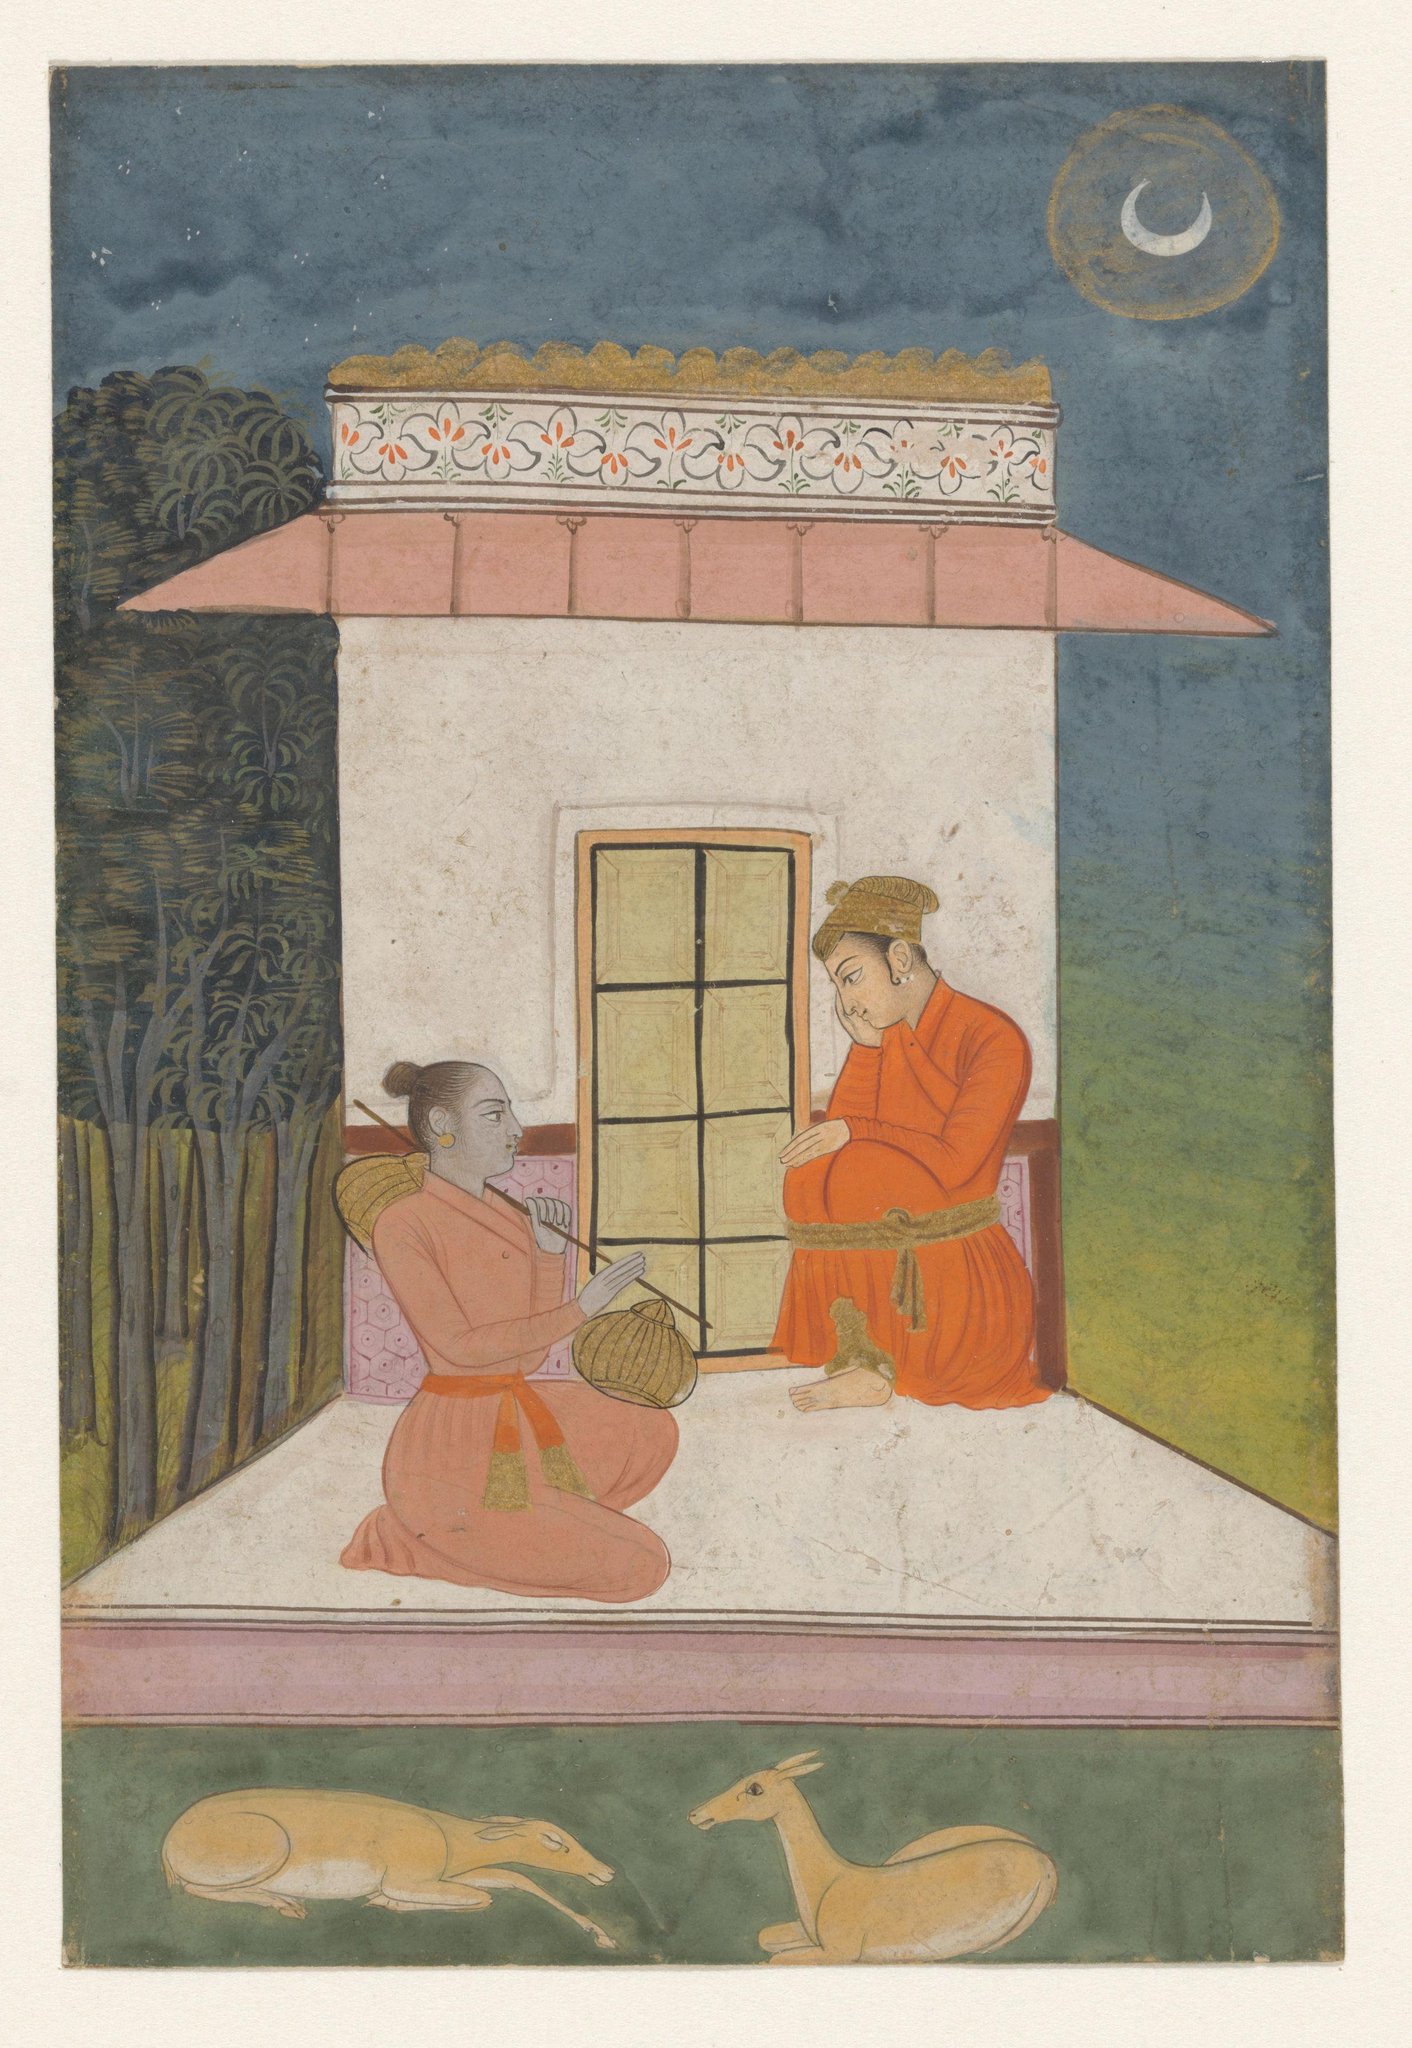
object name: drawing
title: Kedara raga, man en vrouw zittend voor een gebouwtje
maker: Anonymous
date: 1775-1800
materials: paint, gouache, paper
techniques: brush, pen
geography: india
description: Kedara Ragini // Kedararagini. Een man en een asceet met vina zitten voor een gebouwtje. (AK titel)